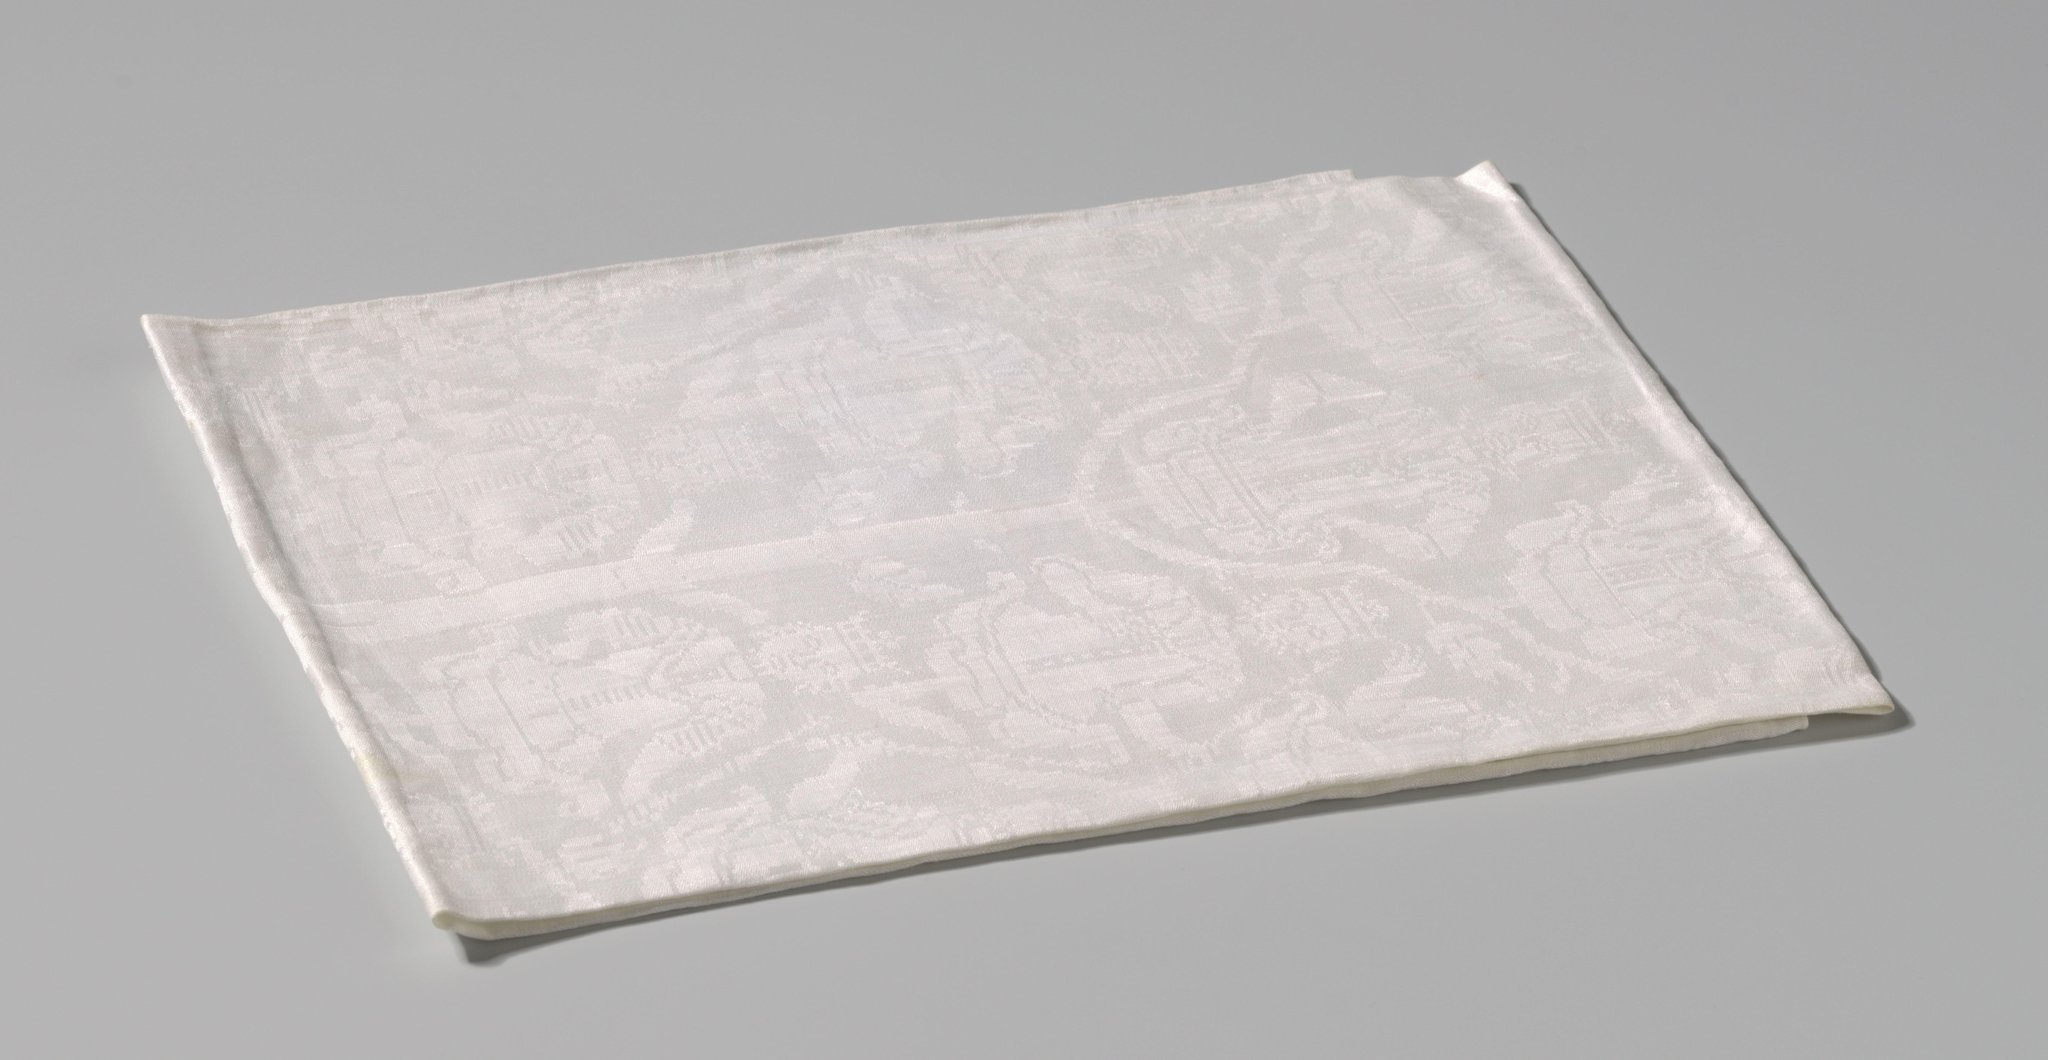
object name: napkin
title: Servet van linnendamast met de boom van Jesse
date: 1600-1625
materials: linen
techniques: damask, weave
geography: netherlands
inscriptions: mark: ‘HK 18’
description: Wit linnendamasten servet met de boom van Jesse. Het servet hoort bij vijf gelijke servetten (BK-1966-145-A t/m BK-1966-145-F).